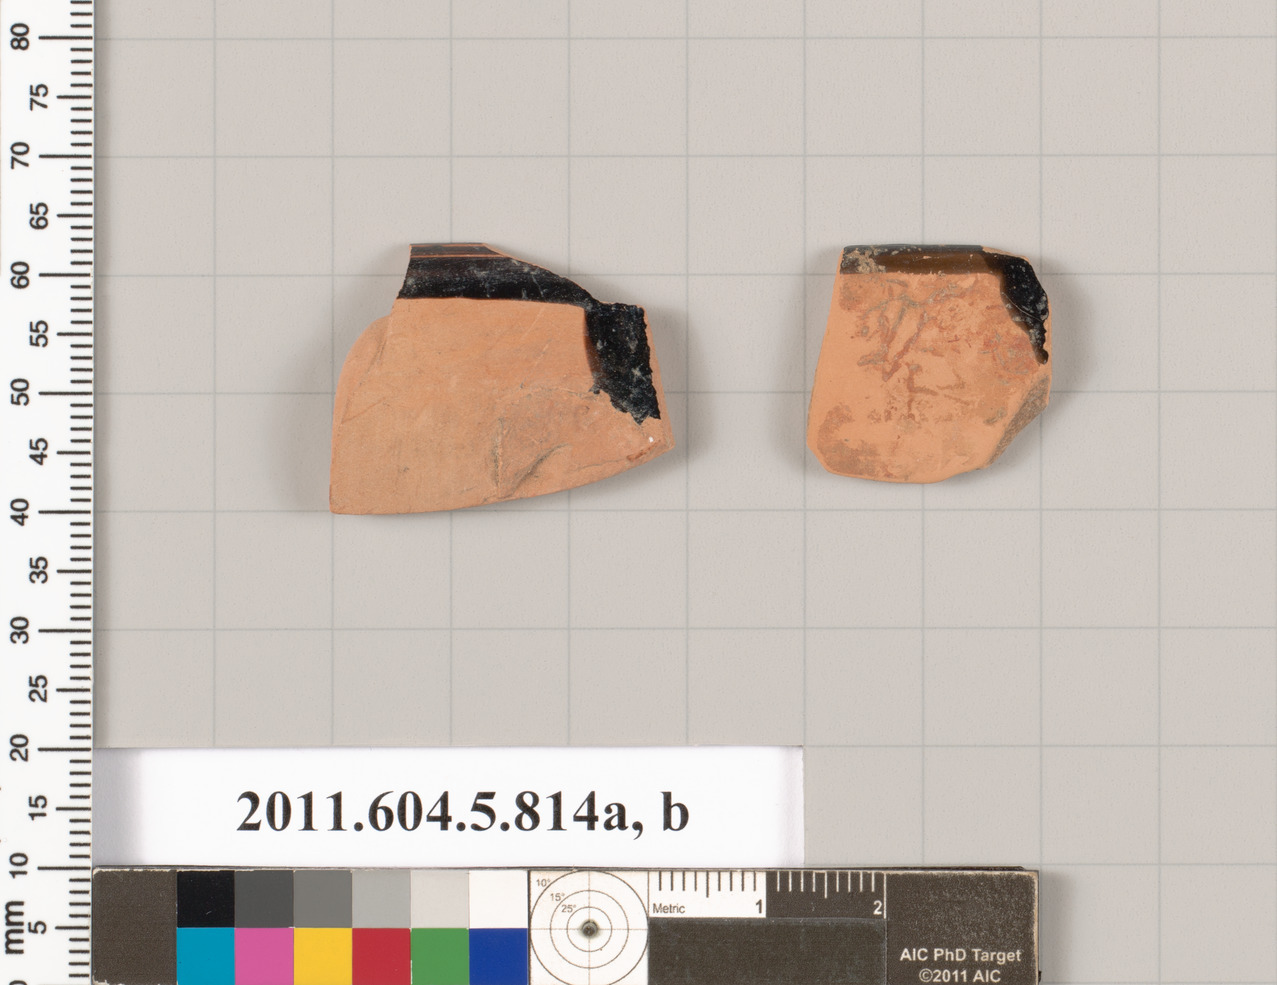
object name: kylix fragment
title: Terracotta rim fragments of kylikes (drinking cups)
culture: greek, attic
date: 600-401 BCE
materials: terracotta